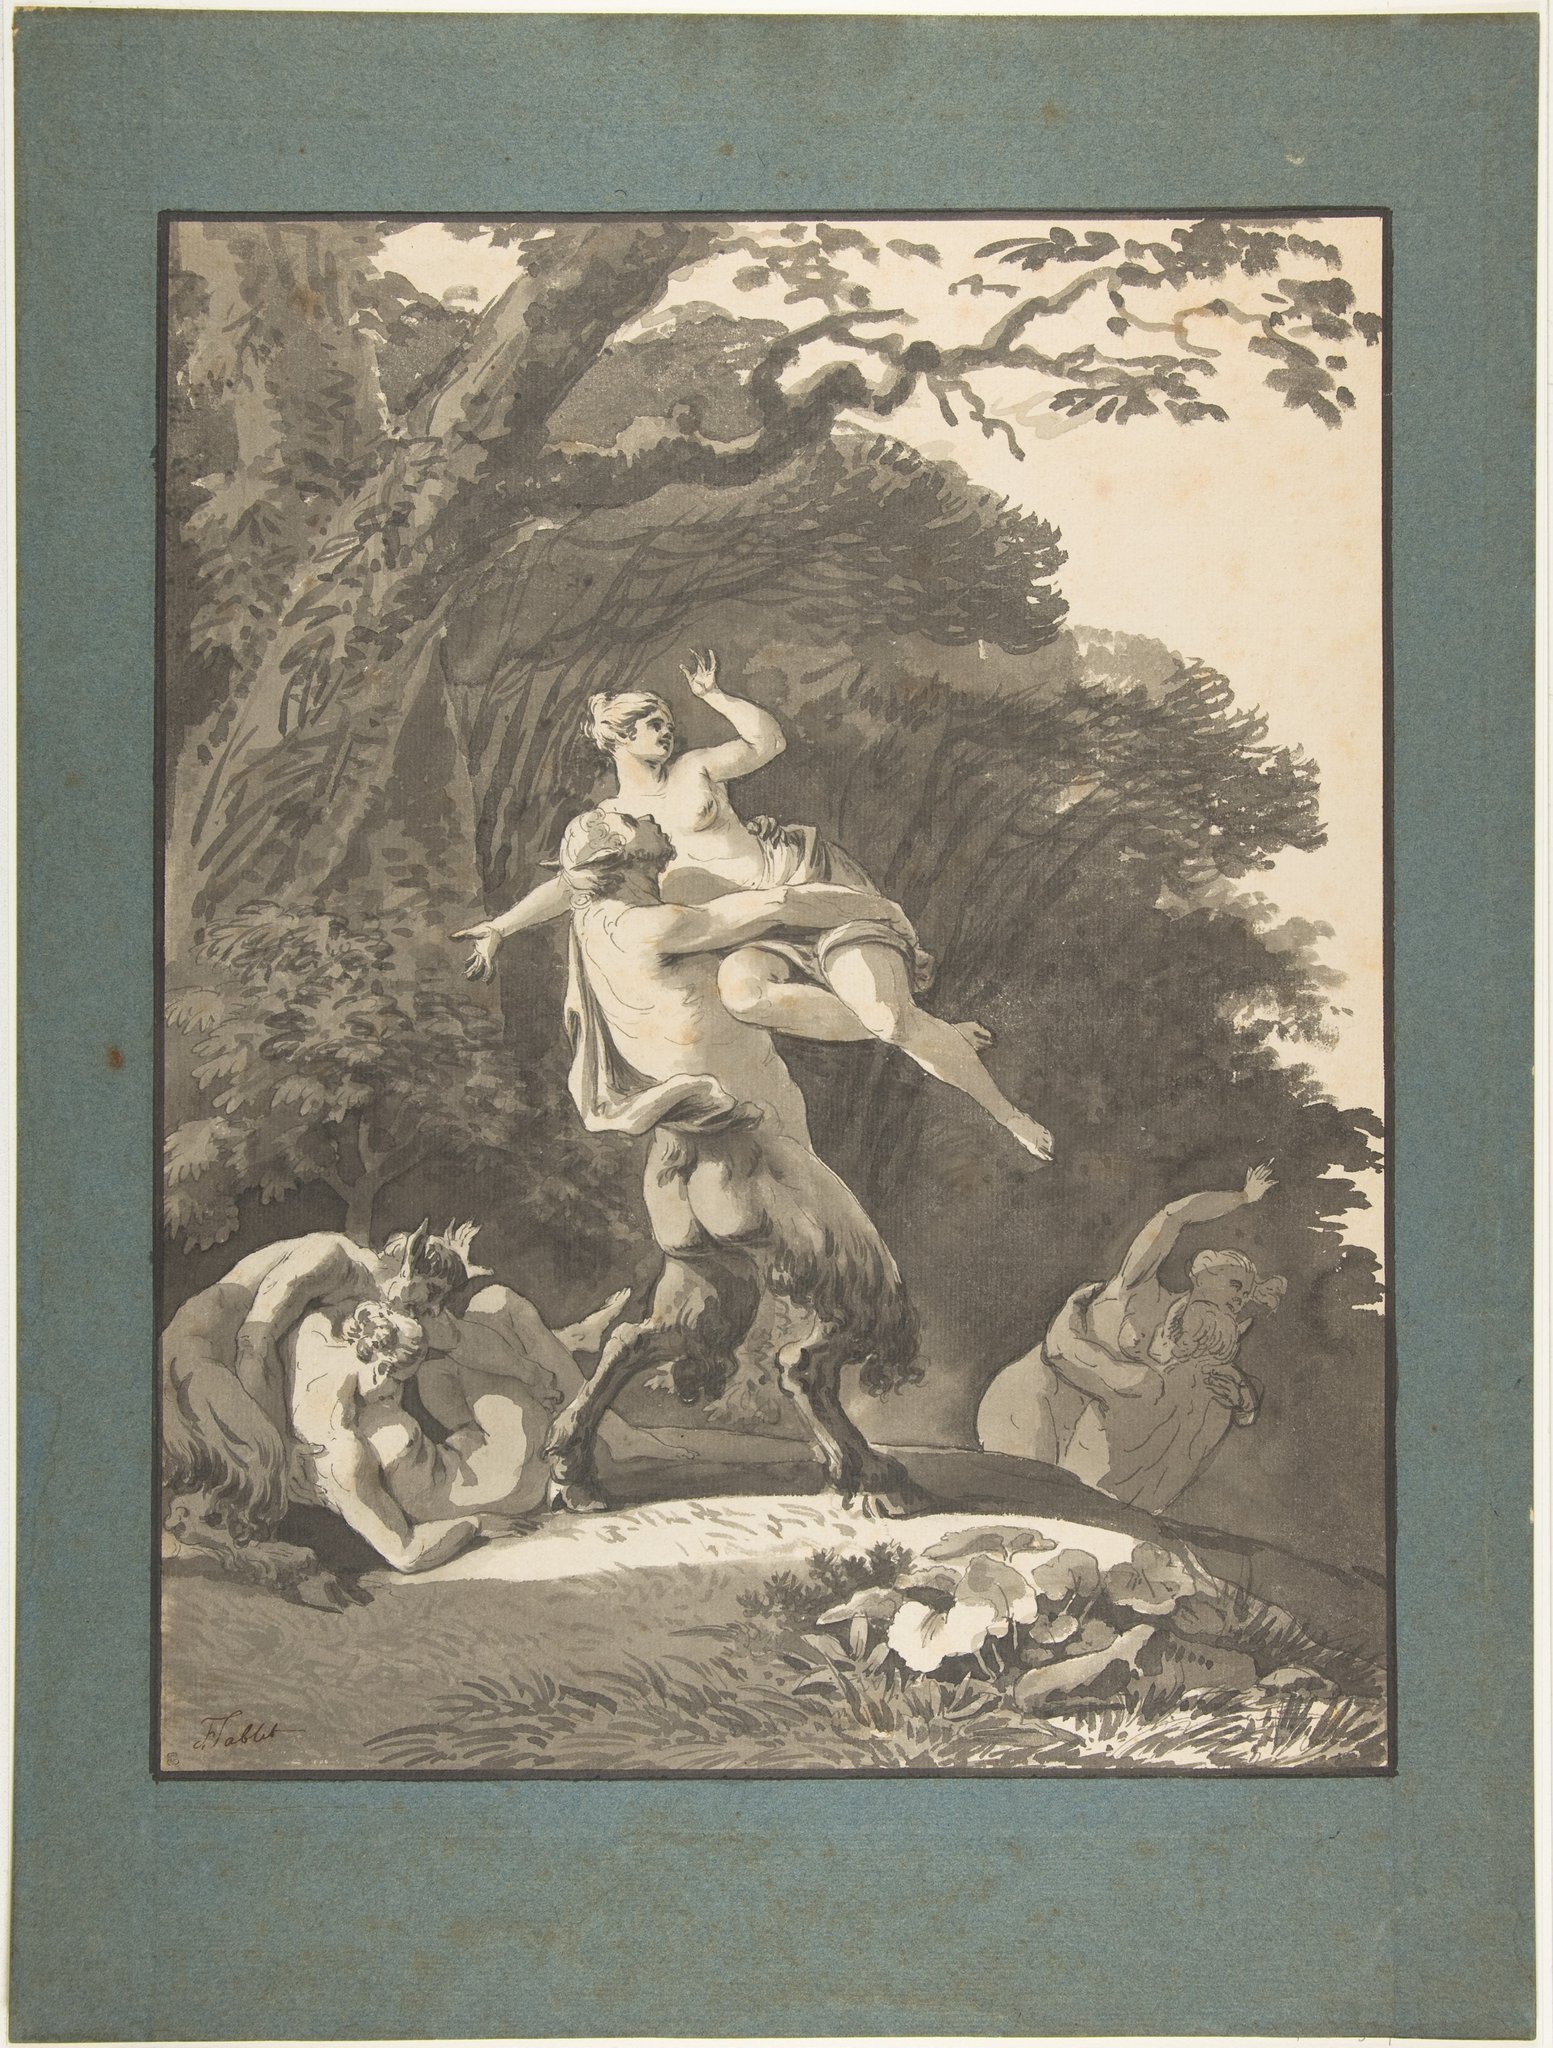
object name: drawing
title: Satyrs Abducting Nymphs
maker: françois jean sablet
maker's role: artist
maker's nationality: french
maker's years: 1745-1819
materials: graphite, ink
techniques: brush, pen, wash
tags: nymphs,satyrs,trees